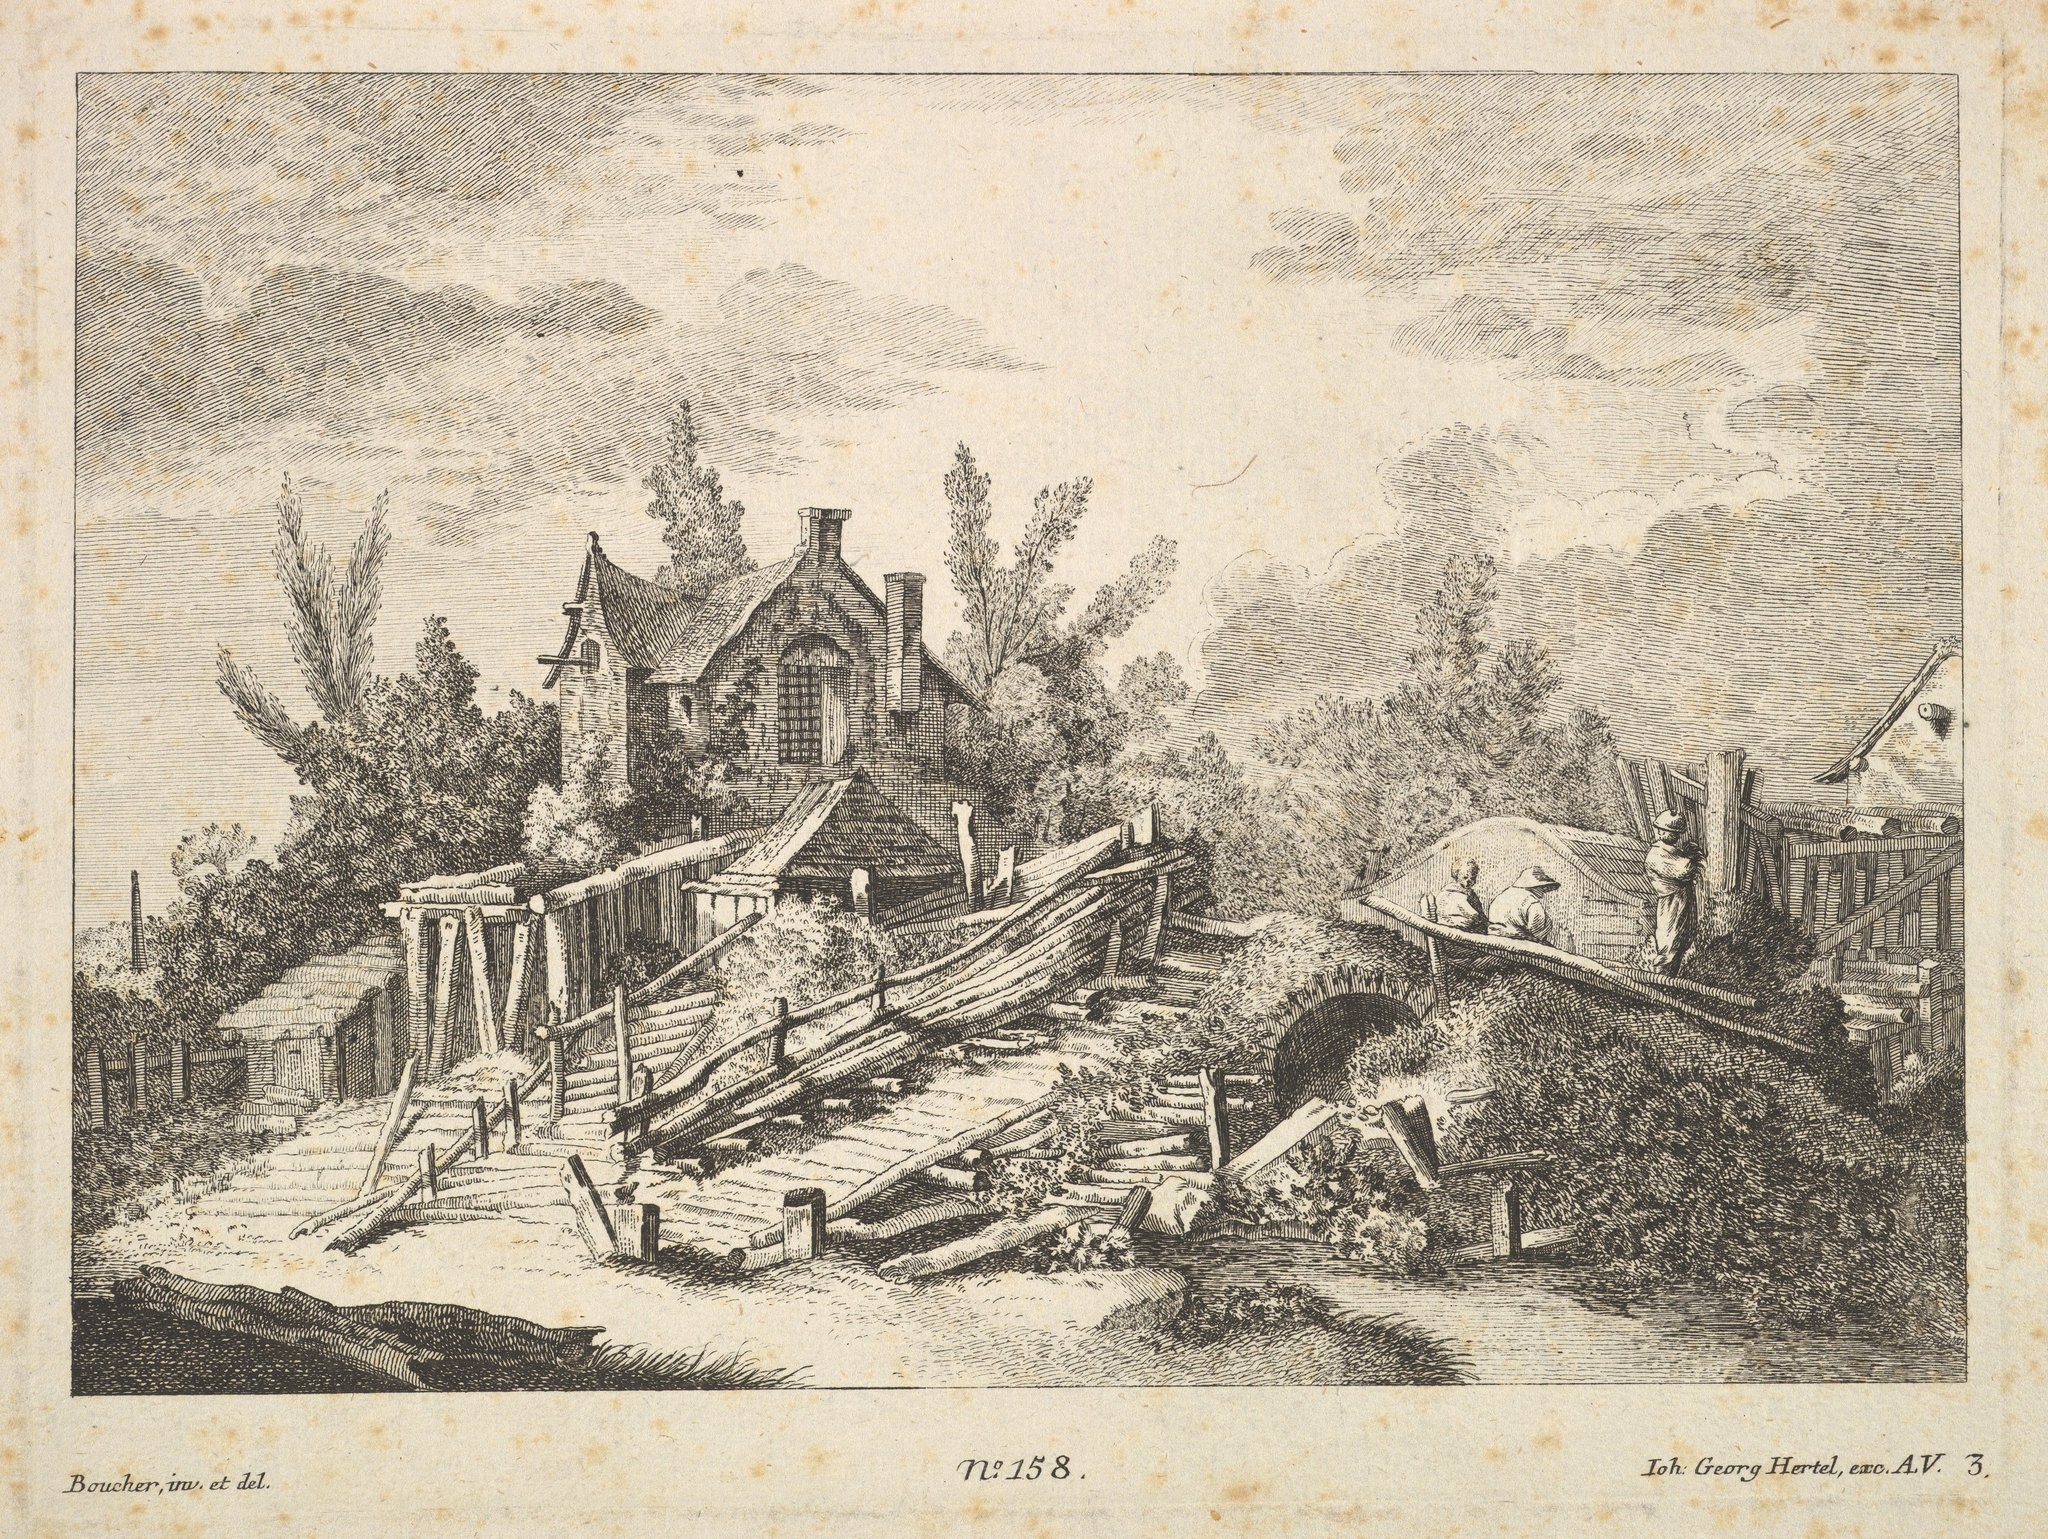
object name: print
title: A Landscape with a Home and Three Men on a Bridge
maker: johann georg hertel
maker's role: artist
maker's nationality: german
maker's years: 1695-1775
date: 1701-1800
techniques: etching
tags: houses,bridges,men,landscapes,trees